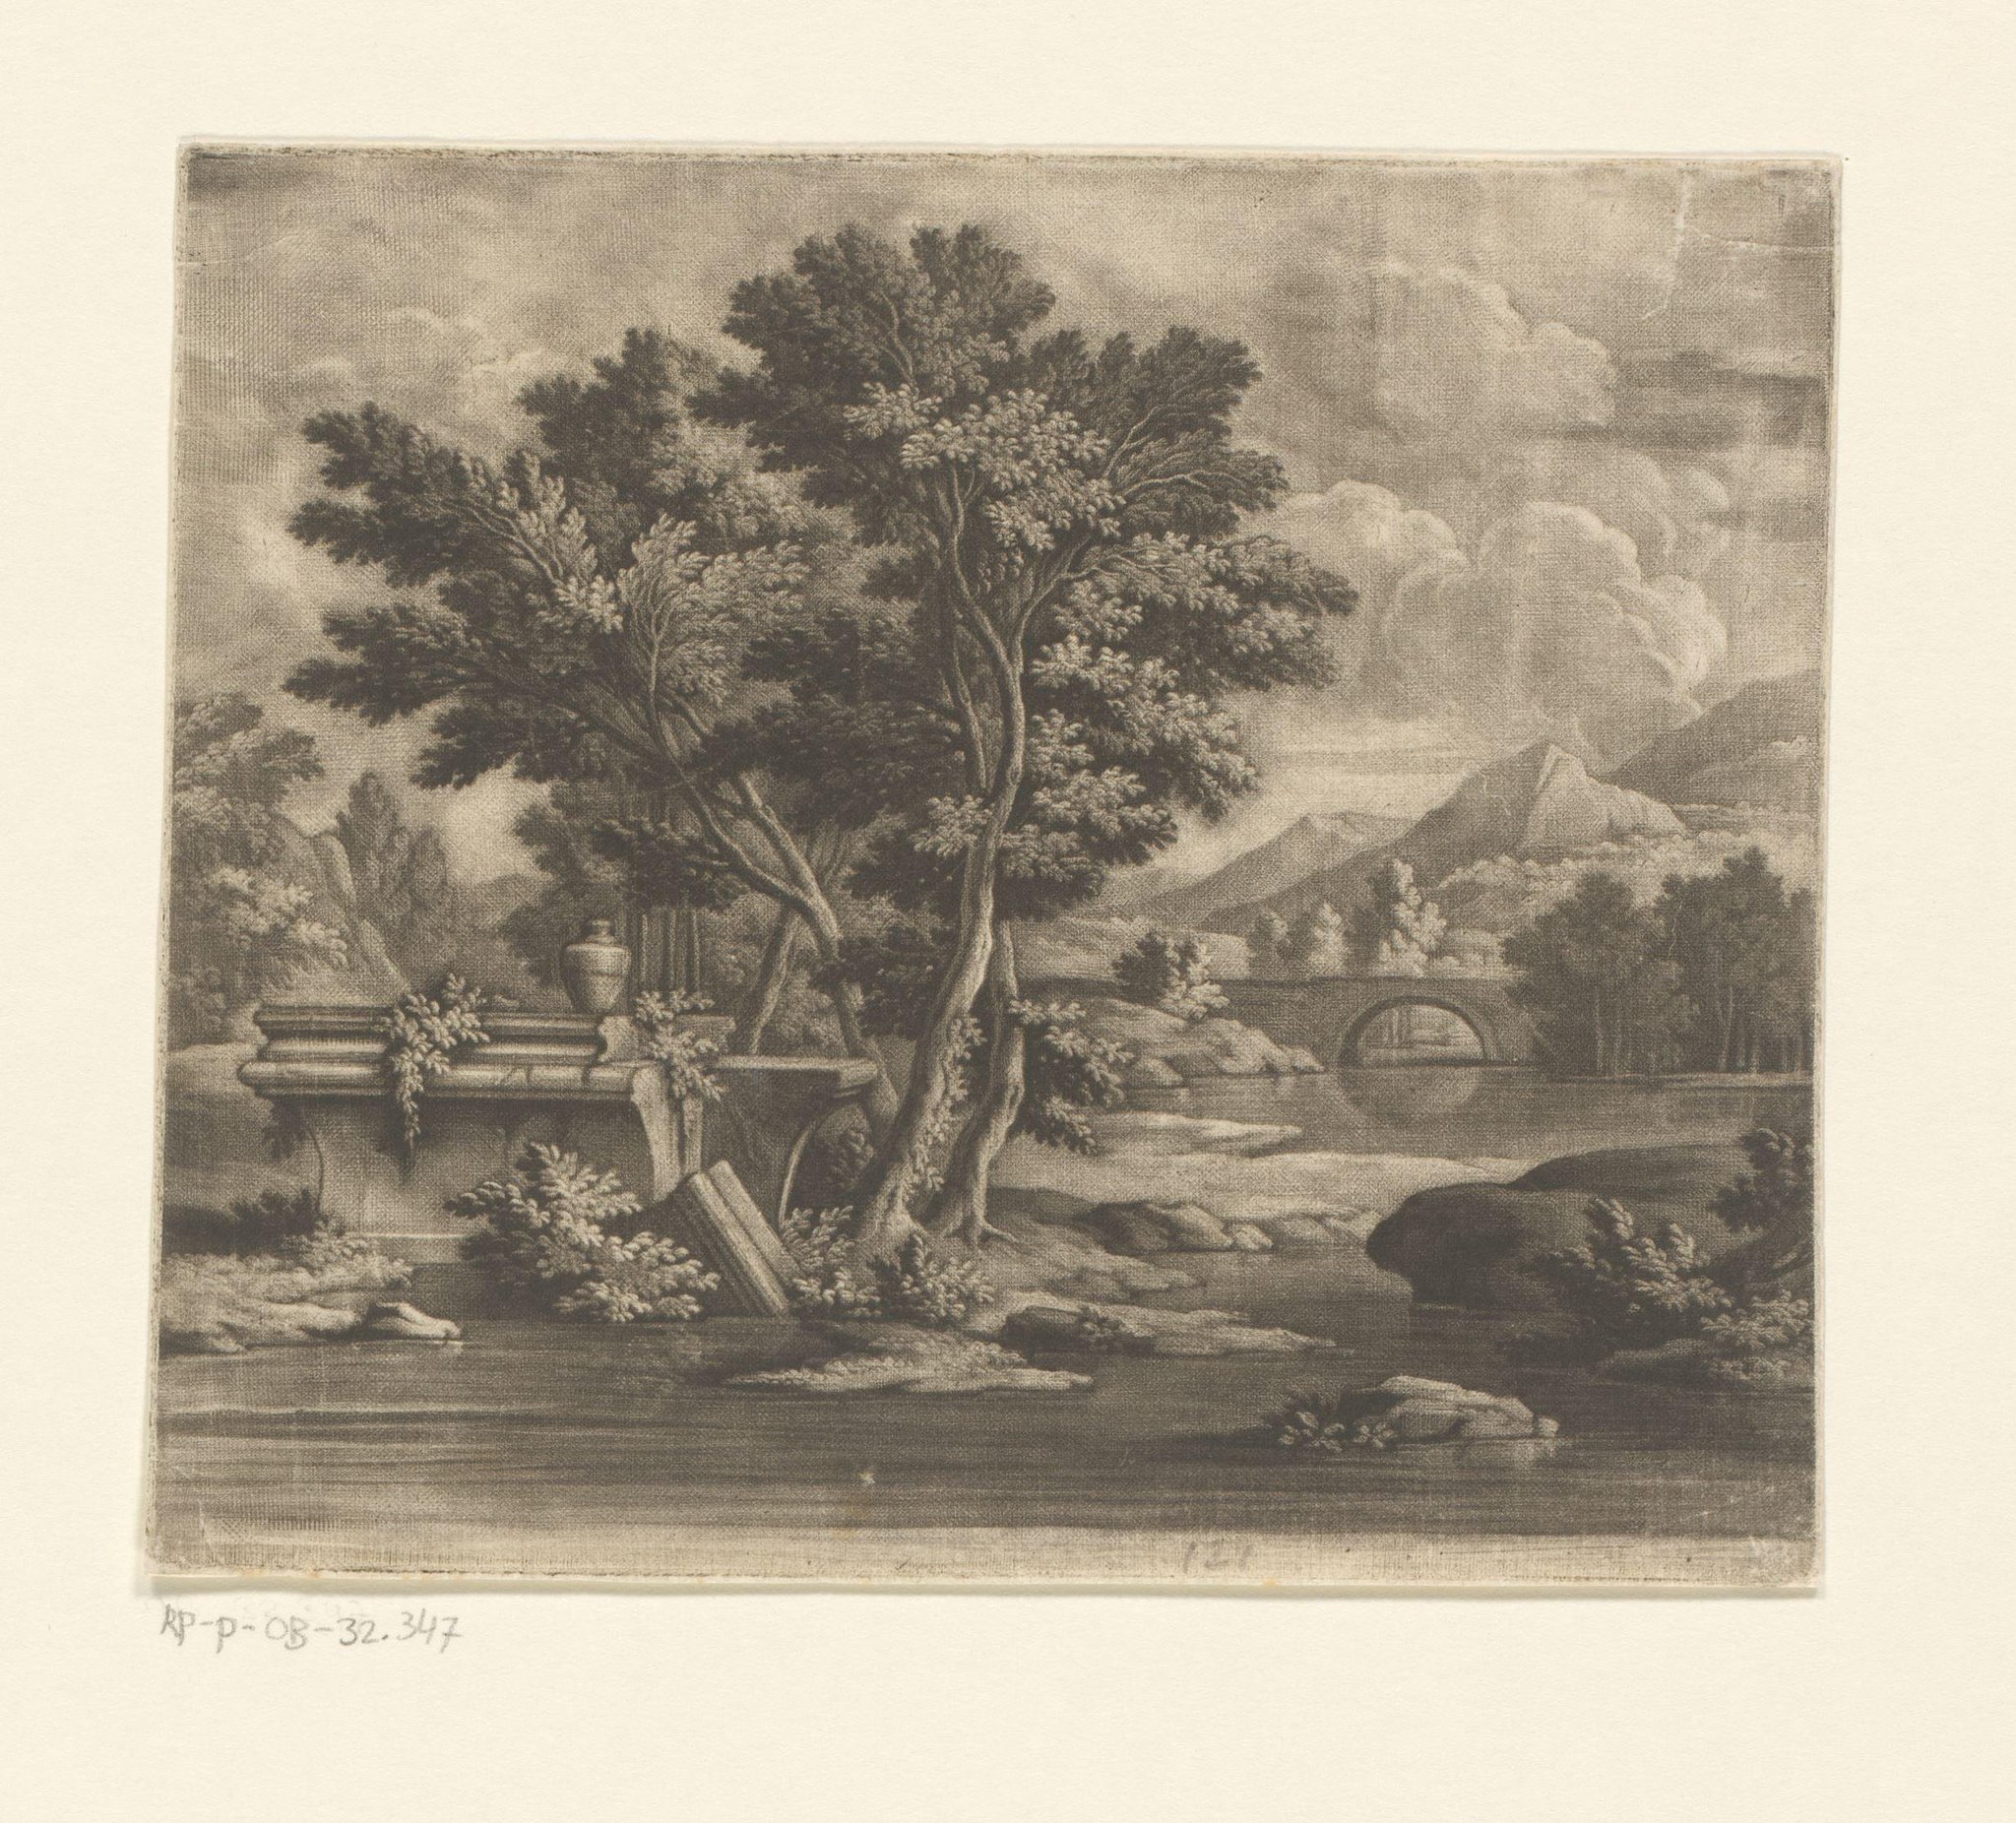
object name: print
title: Tombe aan een rivier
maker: bernard lens (ii)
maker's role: print maker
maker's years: 1659-1725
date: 1669-1725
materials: paper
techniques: mezzotint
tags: dry river, river bed (+ landscape with figures, staffage), grave, tomb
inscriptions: collector's mark: Lugt 240, number: ‘121’